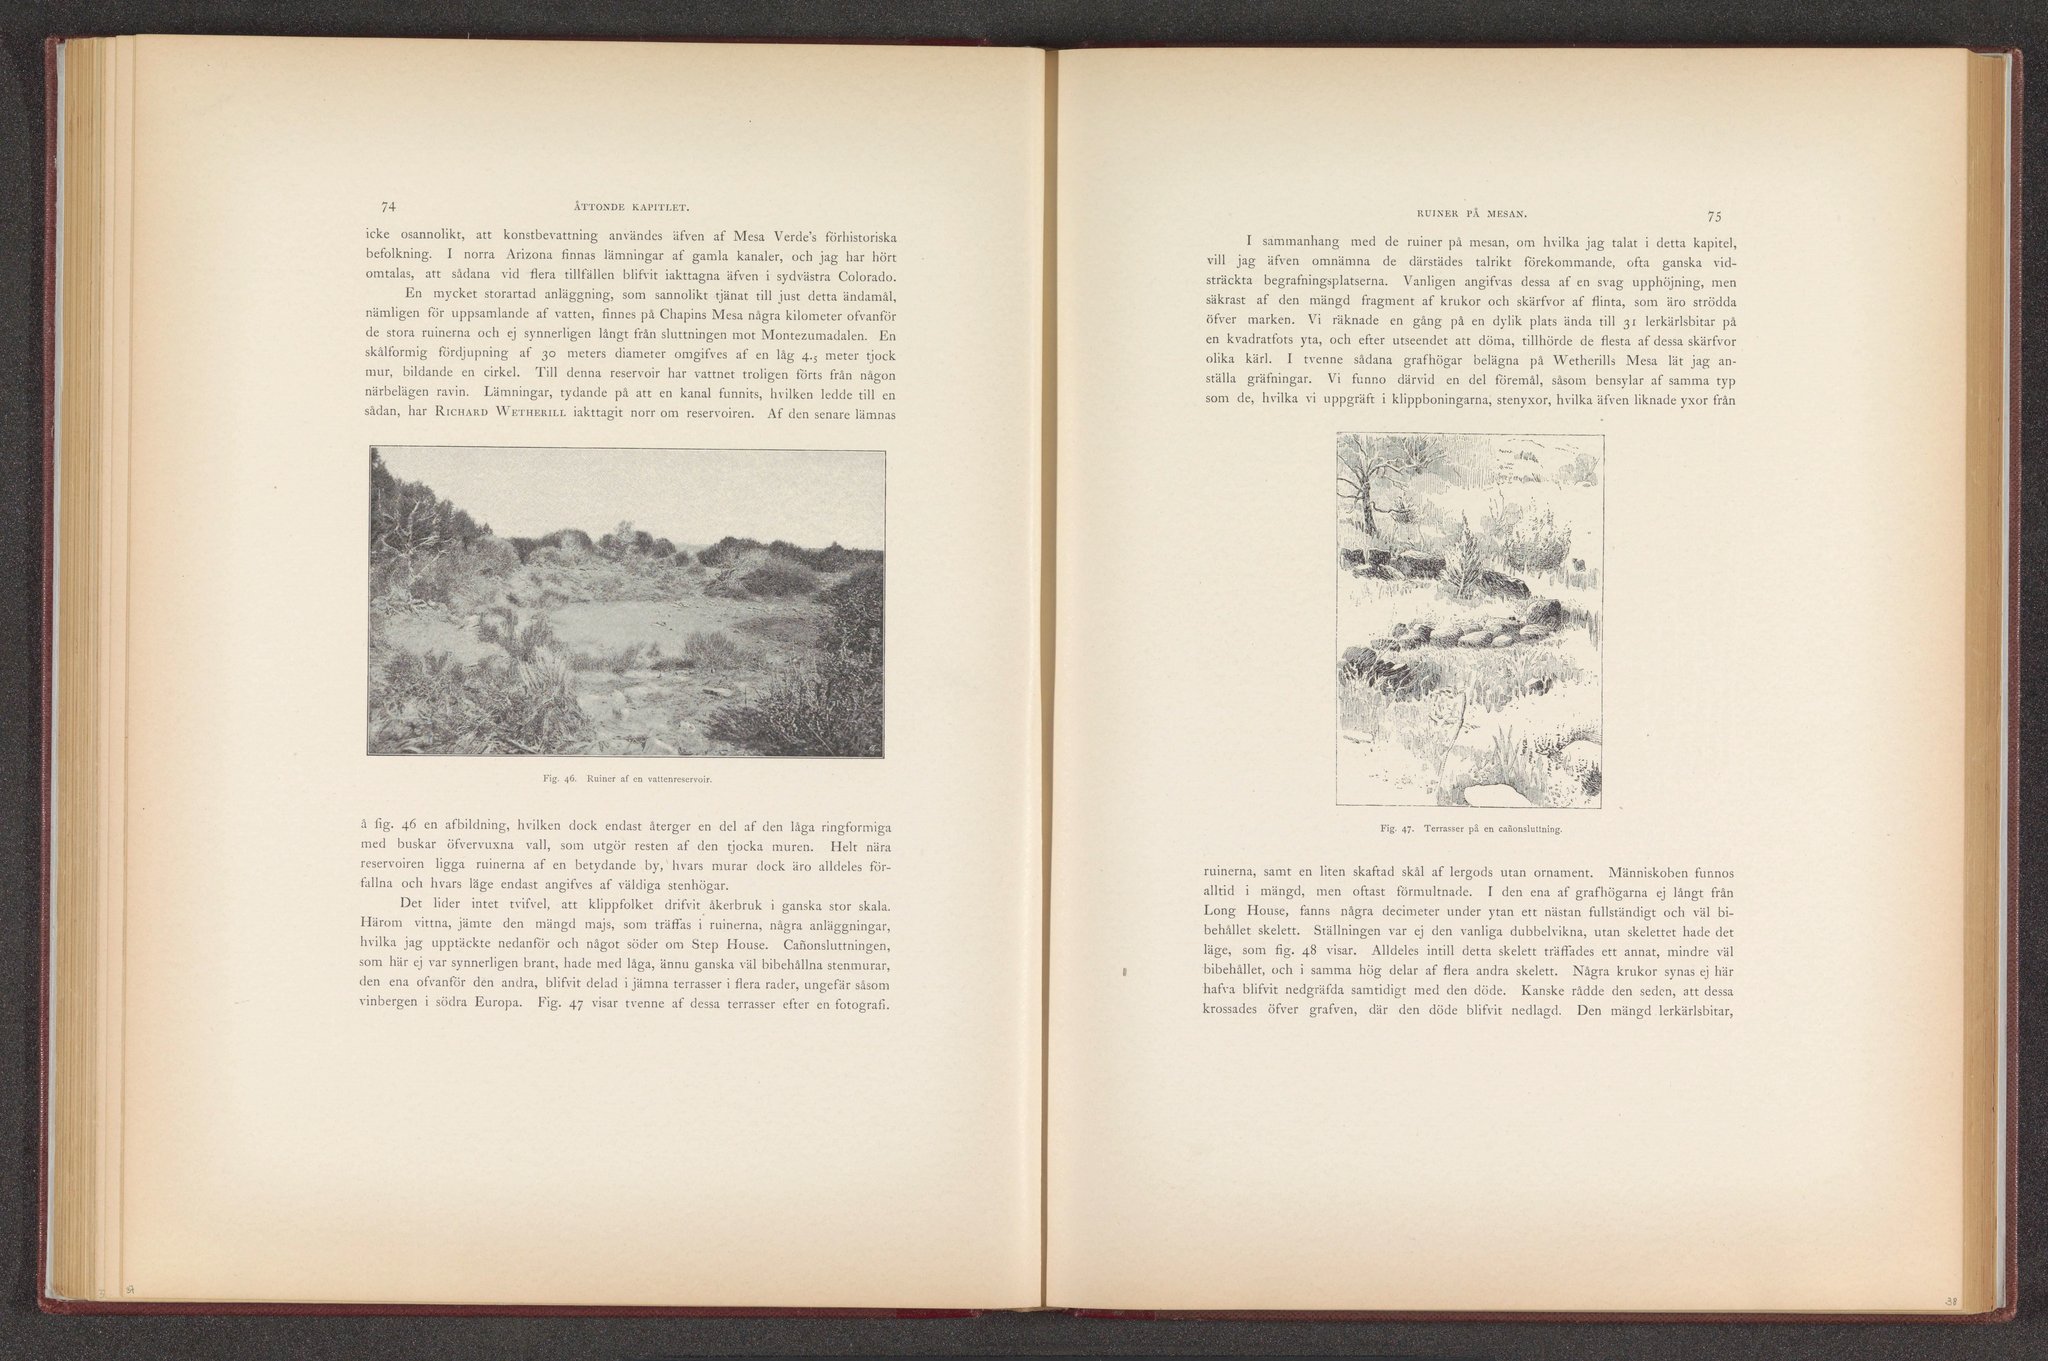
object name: page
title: Ruiner af en vattenreservoir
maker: gustaf nordenskiöld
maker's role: fotograaf, schrijver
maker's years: 1868-1895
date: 1891-1893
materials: paper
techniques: autotype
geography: vienna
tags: ruin of a building ~ architecture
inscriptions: name, number: ‘Fig. 46.’